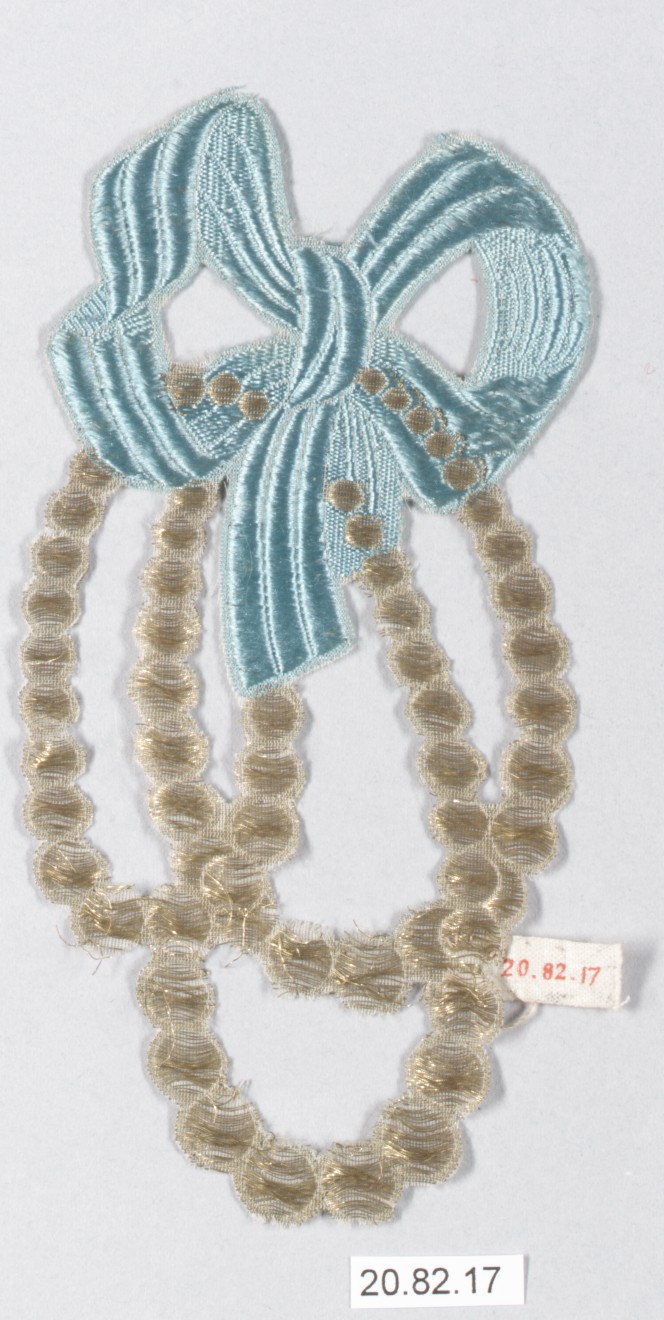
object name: passementerie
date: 1801-1833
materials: metal thread, silk